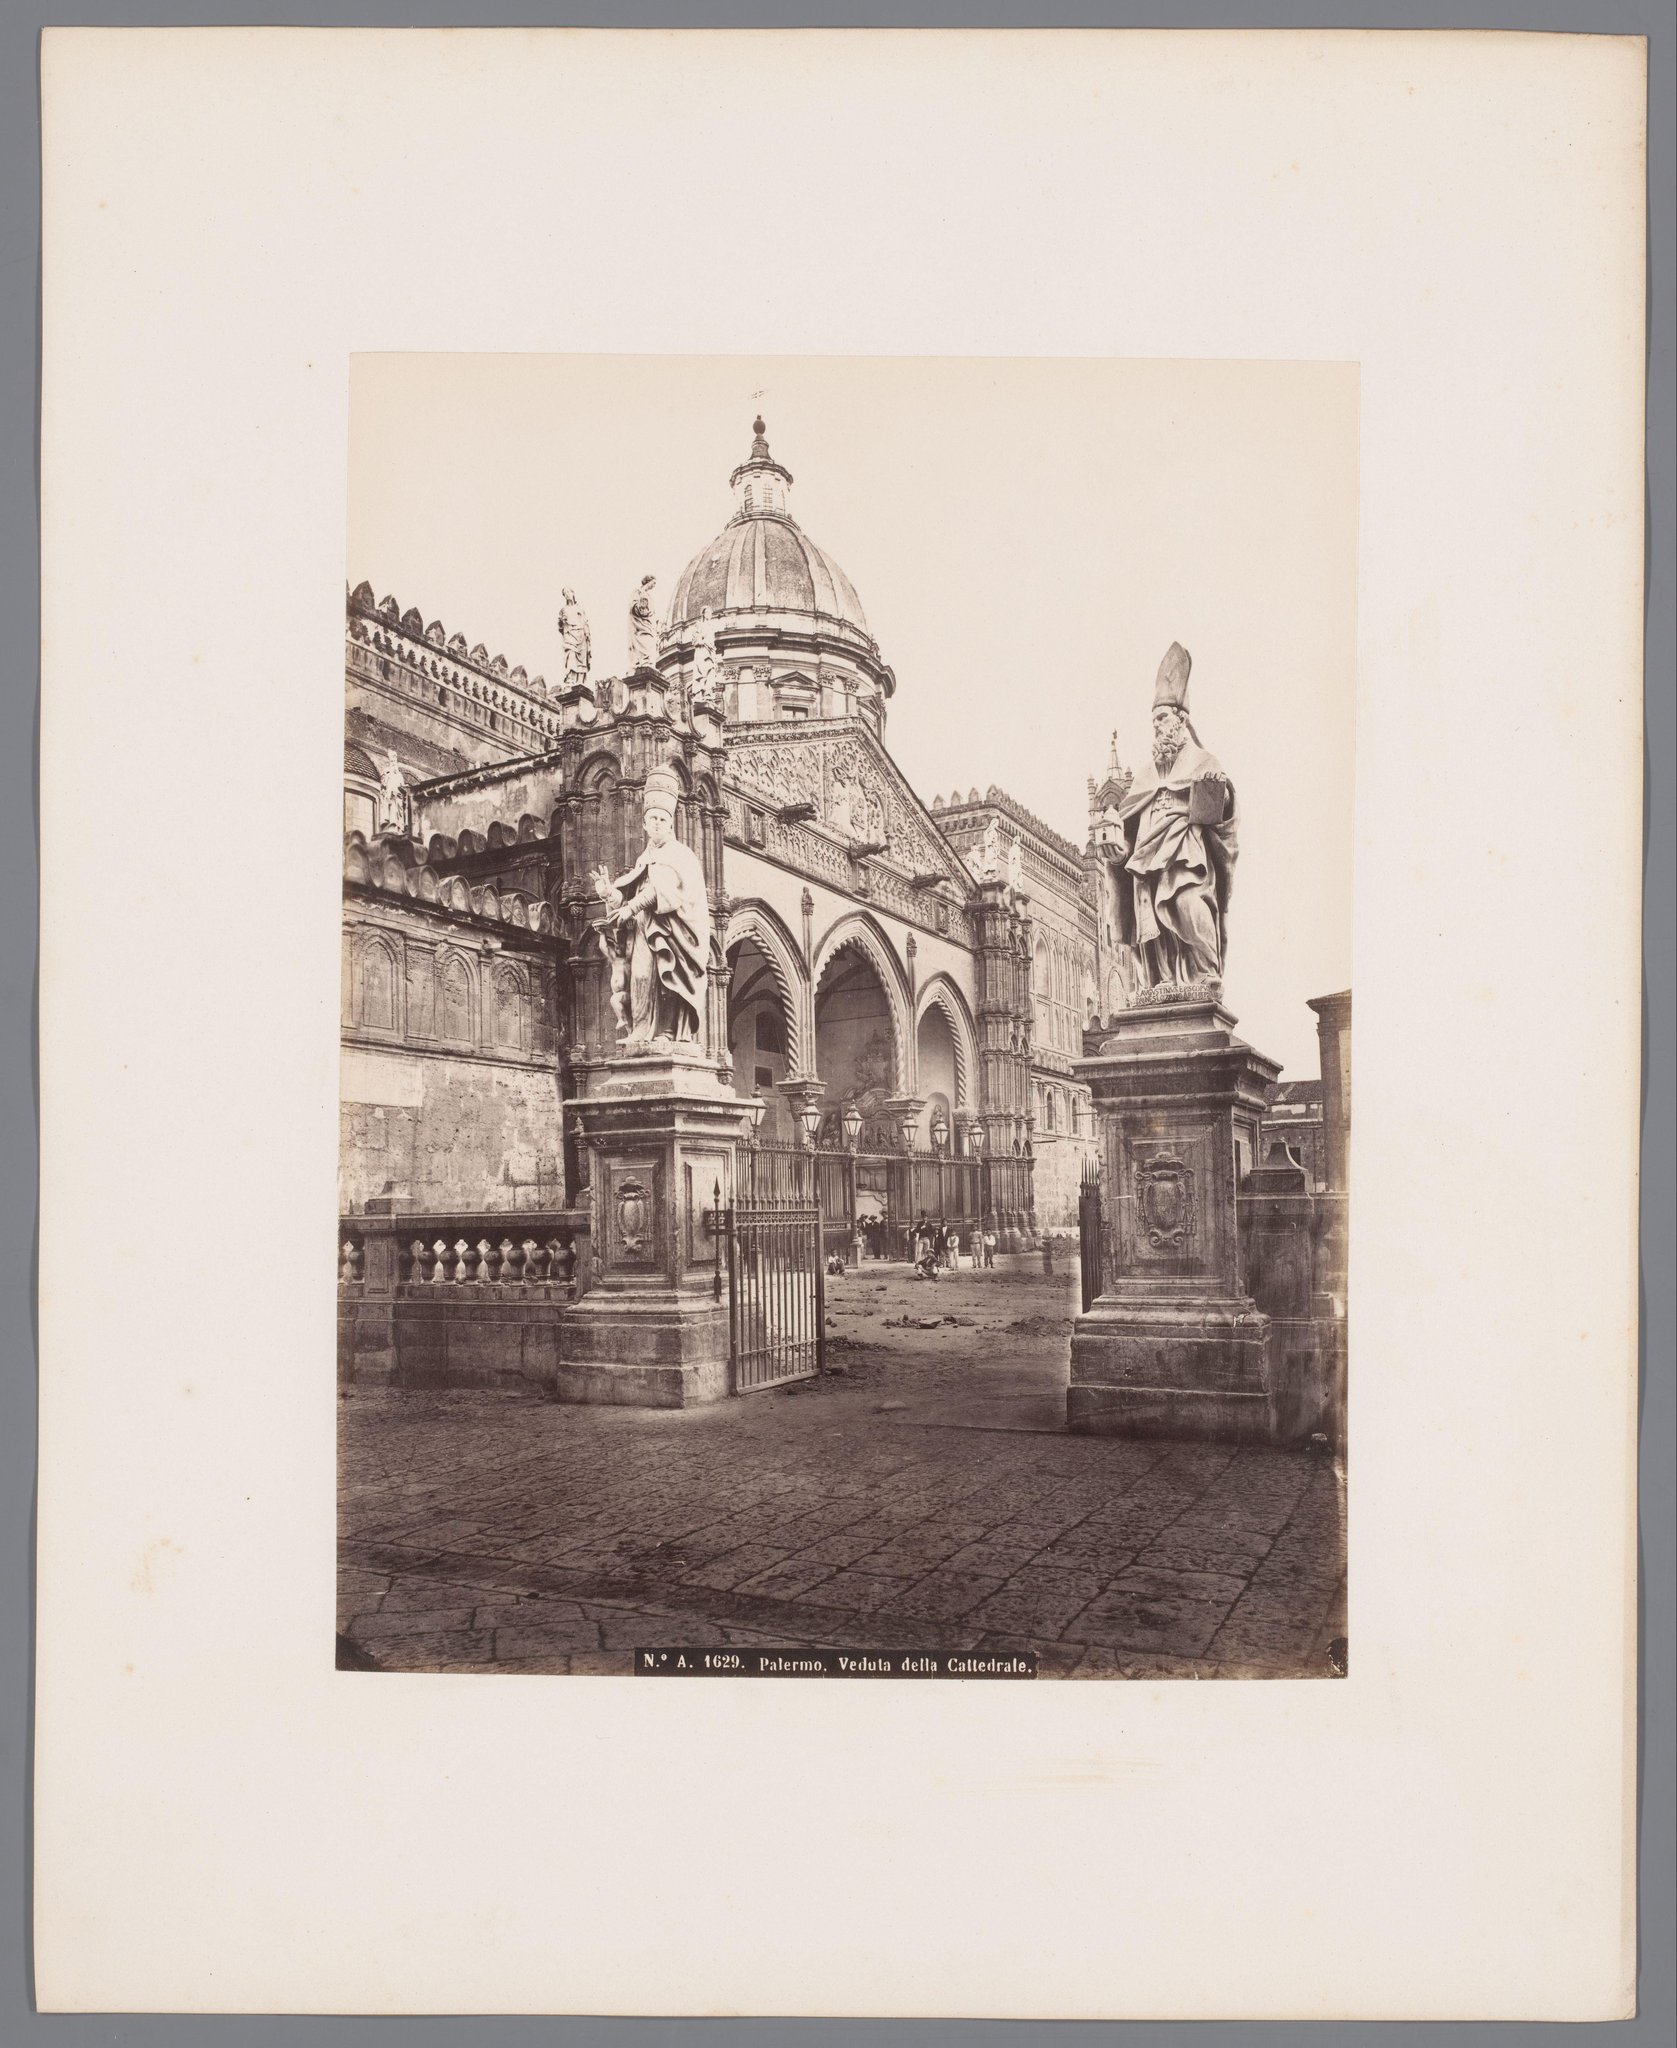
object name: photograph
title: Palermo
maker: roberto rive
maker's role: fotograaf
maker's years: 1825-1868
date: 1860-1889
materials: cardboard, paper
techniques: albumen print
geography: palermo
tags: church (exterior)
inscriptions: inscription: ‘Rive (t)’, number: ‘No. A. 1629.’